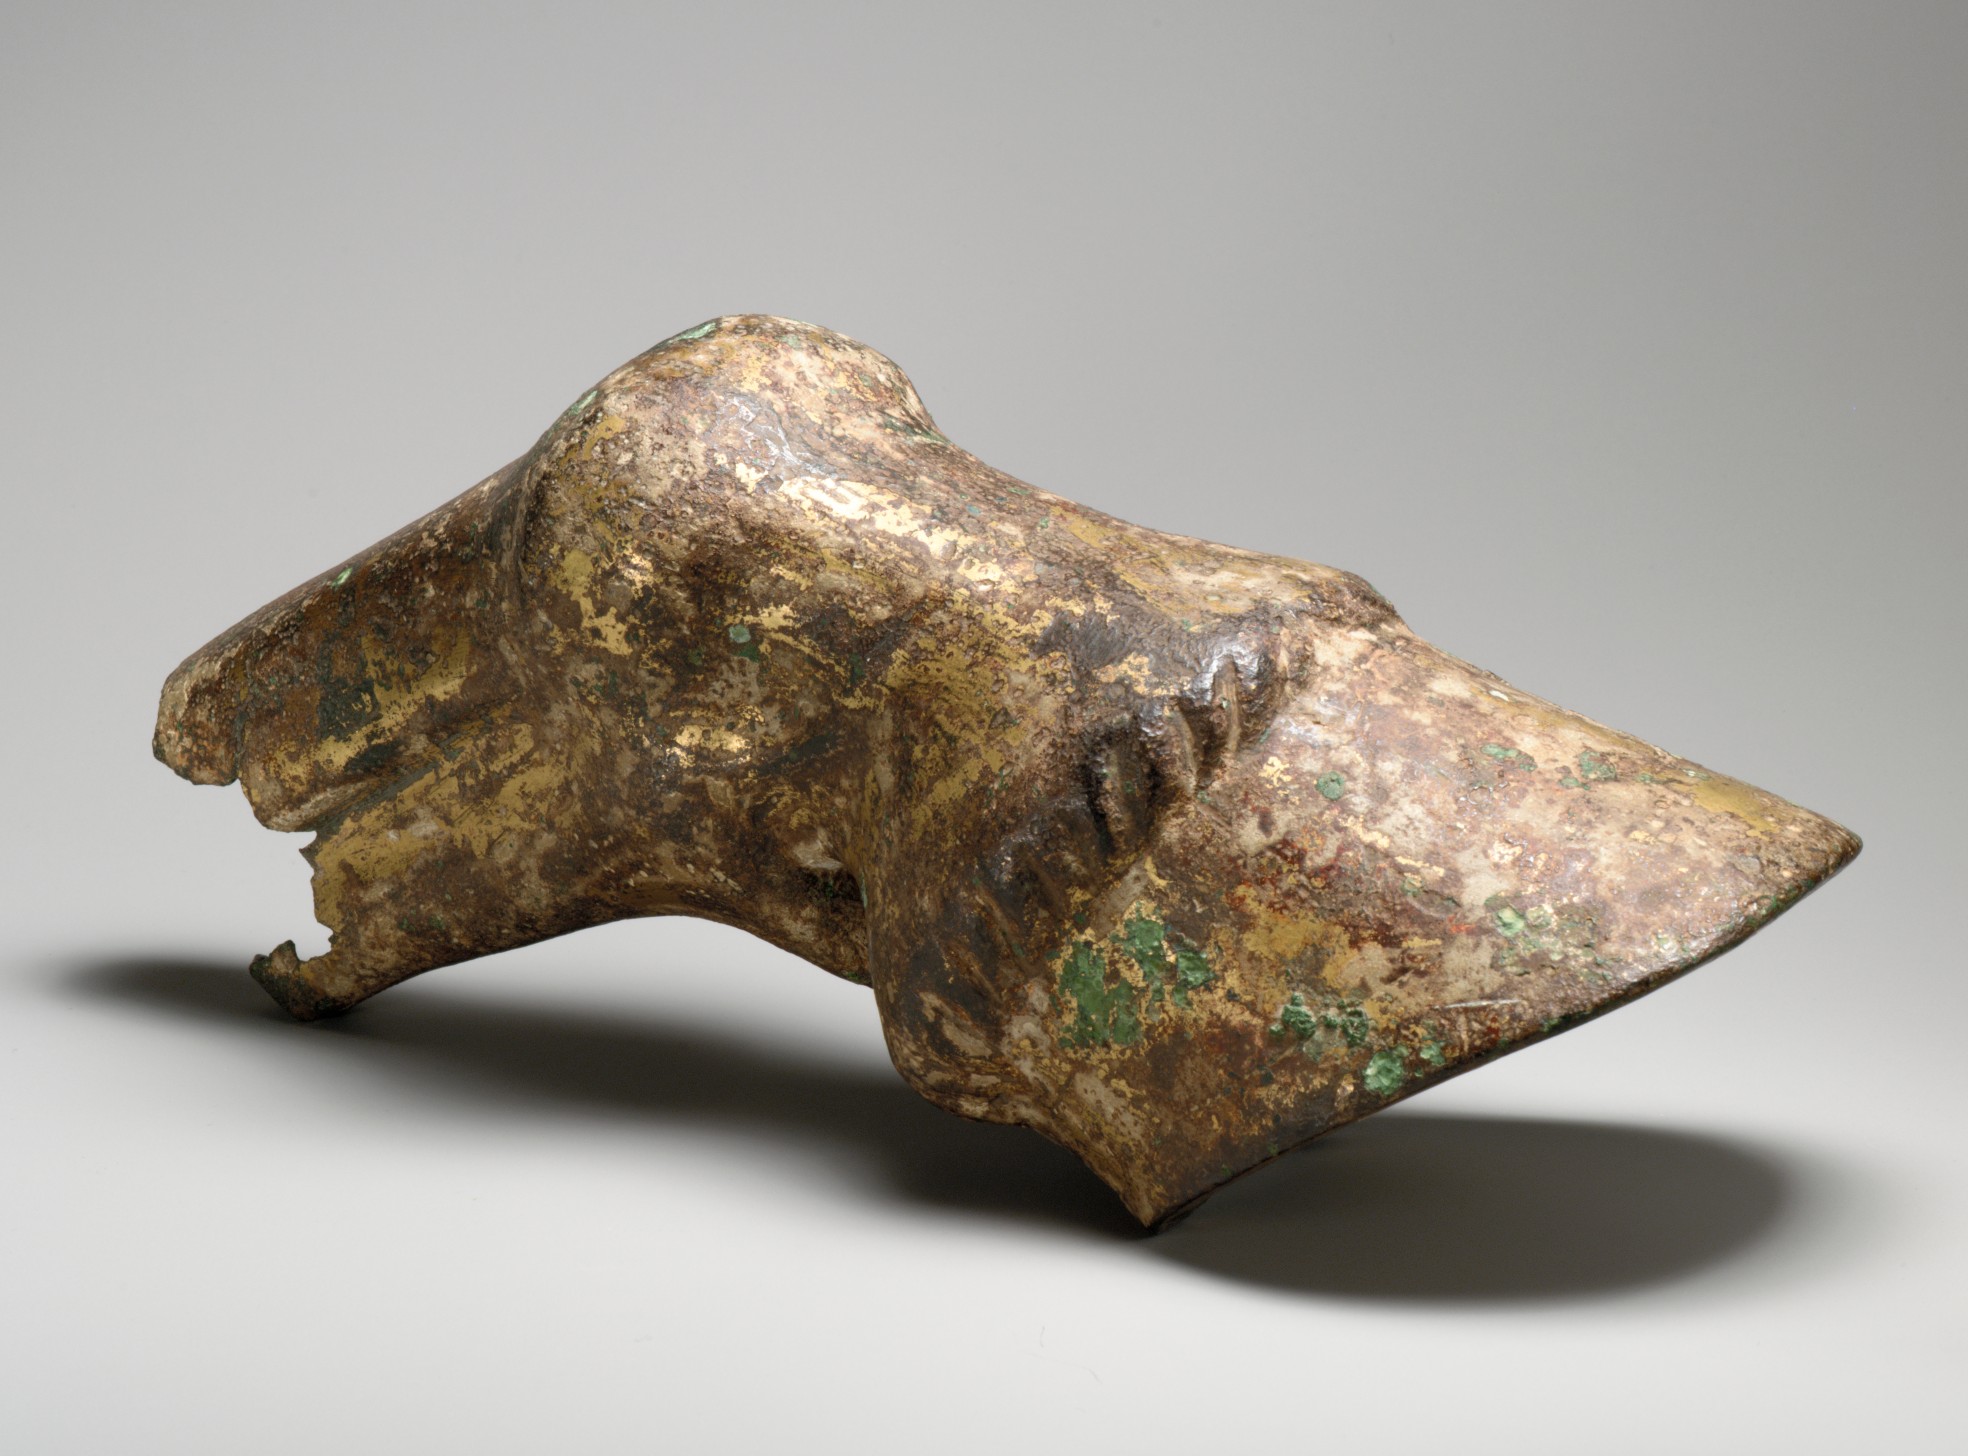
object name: horse leg and hoof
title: Gilt bronze horse's hoof and fetlock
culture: roman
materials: bronze, gold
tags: feet,horses